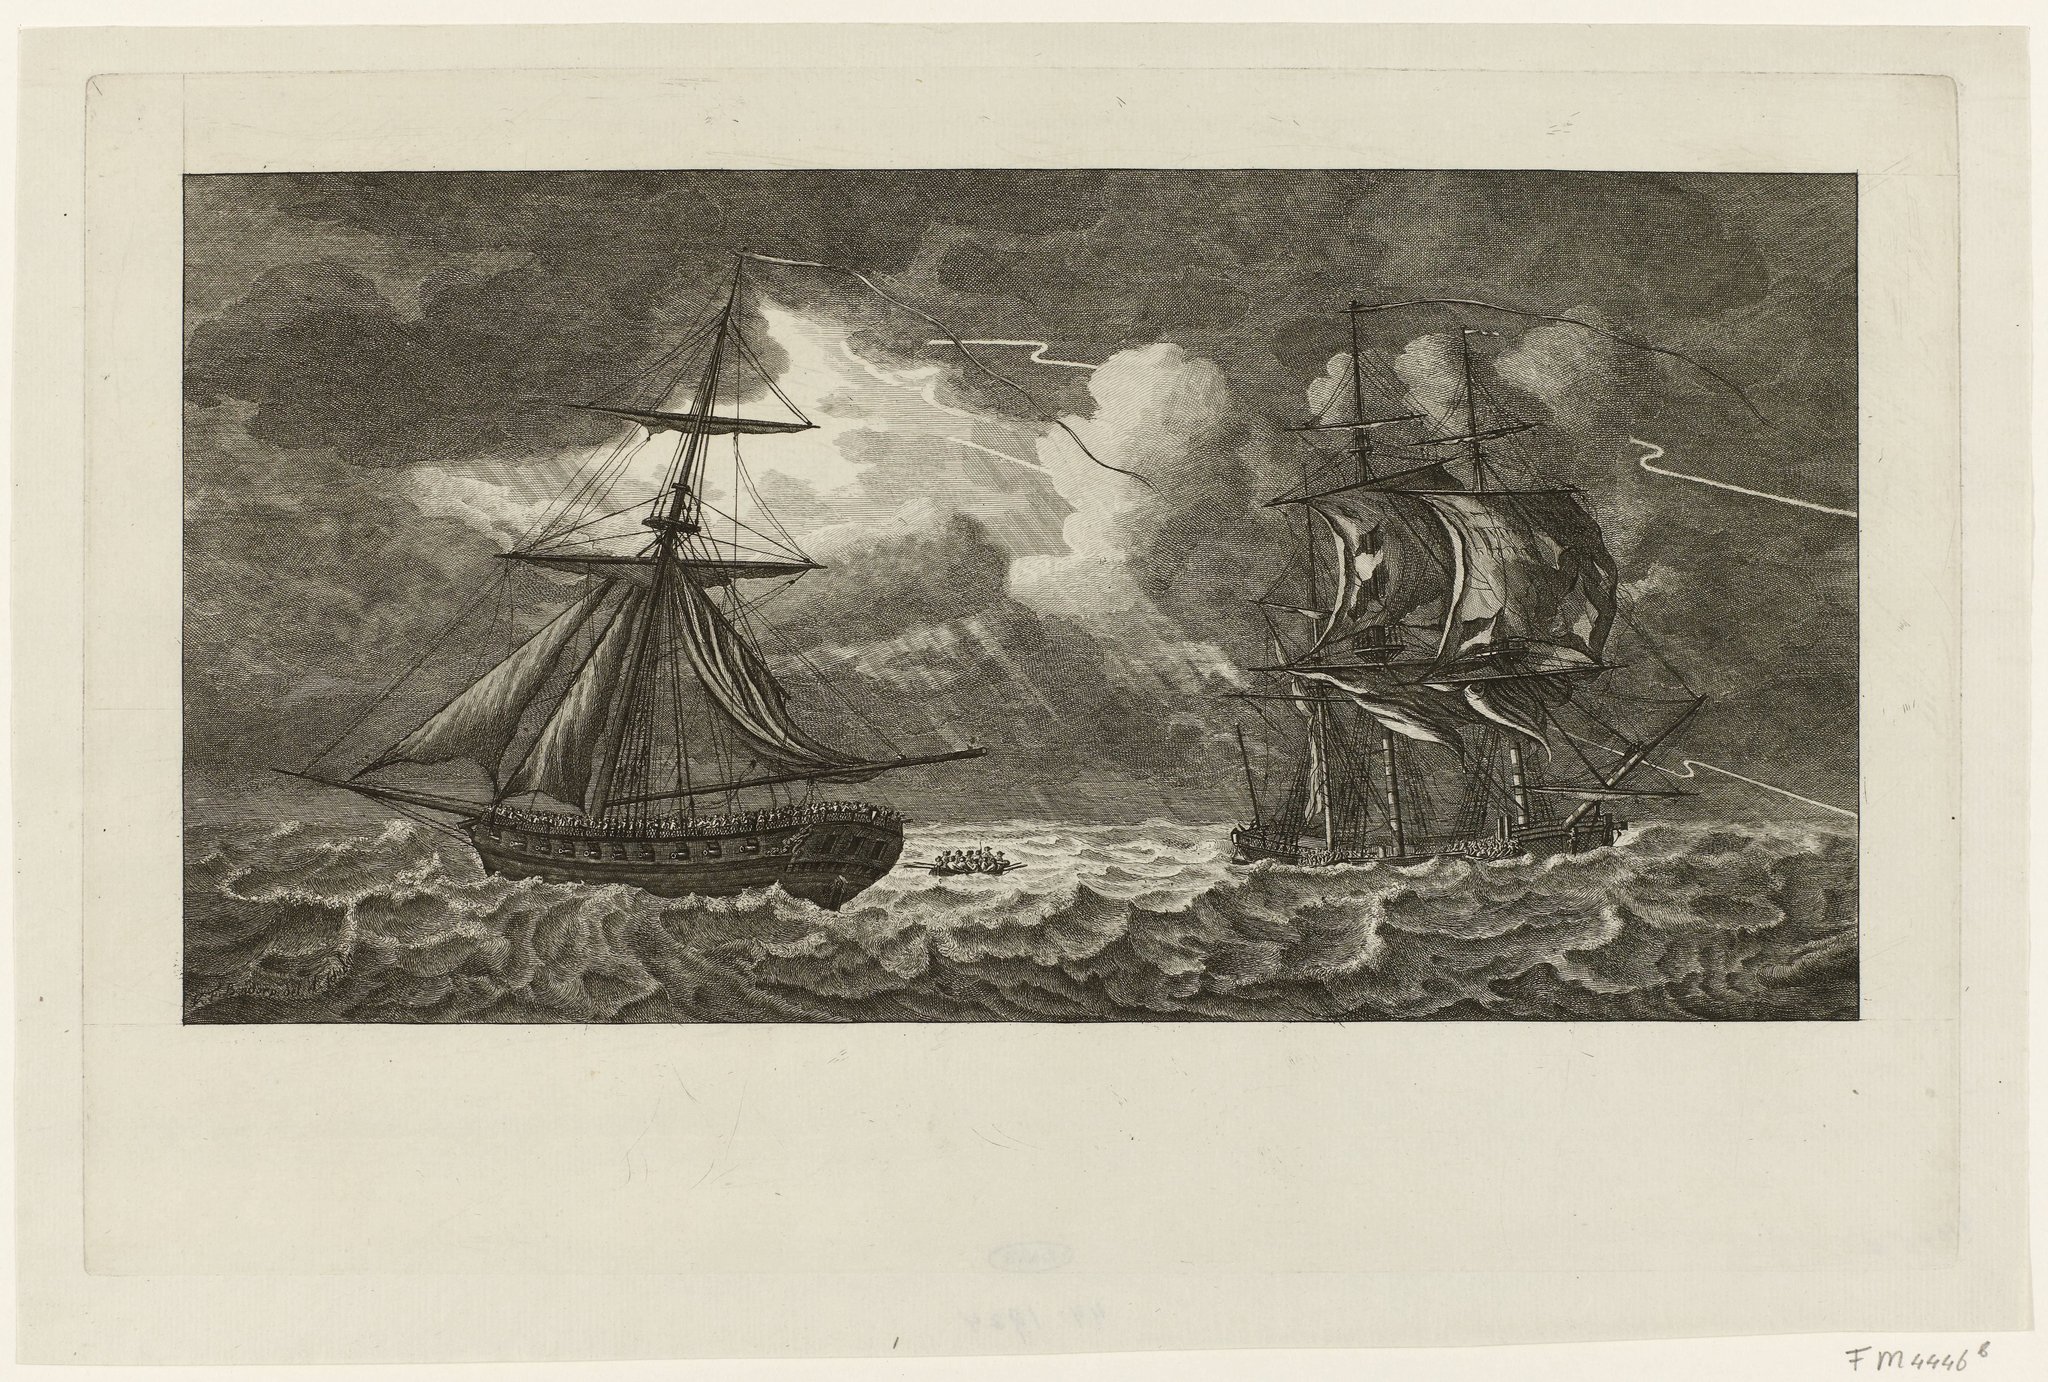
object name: print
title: Tweede en Laatste stel van Vier Kunstplaaten, verbeeldende Vaderlandsche Historien ter Zee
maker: carel frederik bendorp (i)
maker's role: print maker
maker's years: 1736-1814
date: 1784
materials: paper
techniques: engraving, etching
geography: northern netherlands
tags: shipwreck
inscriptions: collector's mark: Lugt 2228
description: Het redden van de bemanning van het zwaar gehavende schip Holland, na de zeeslag bij Doggersbank op 5 augustus 1781 tussen de Nederlandse en de Engelse vloot. Onderdeel van een serie van historische gebeurtenissen op zee in de jaren 1781-1784, tweede serie.